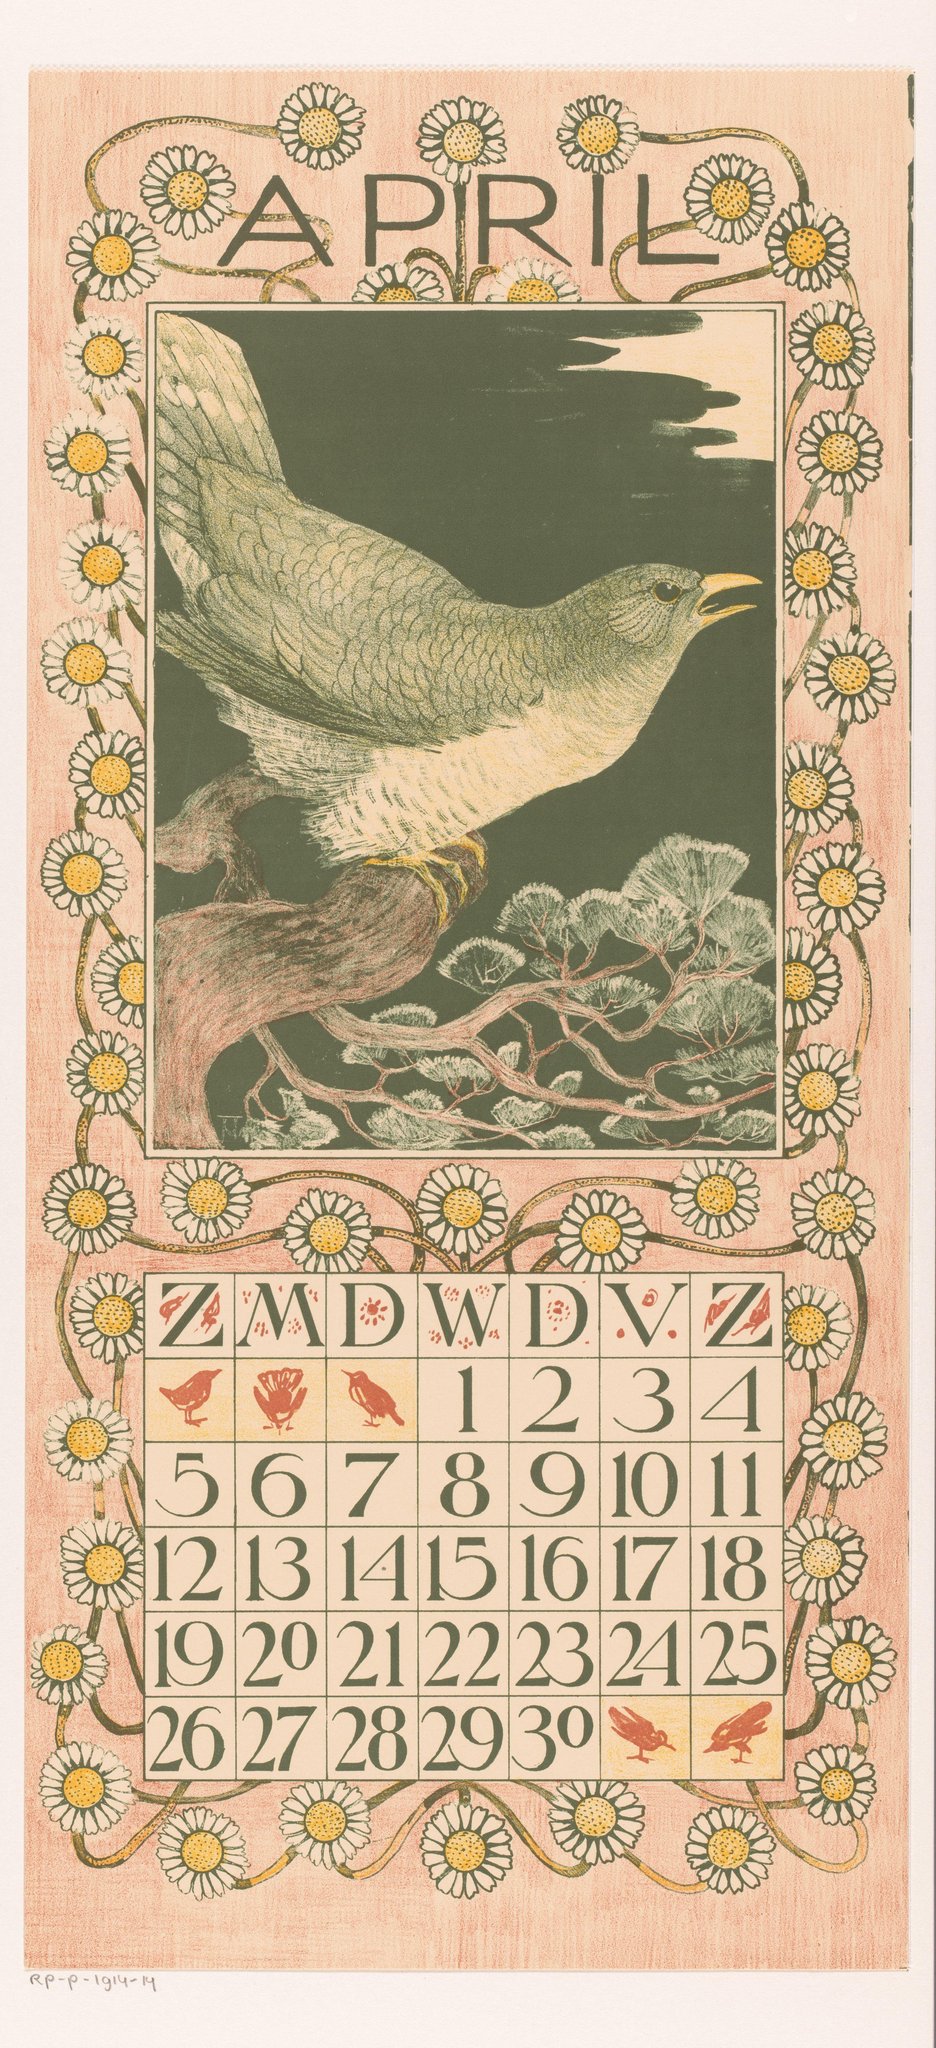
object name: print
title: Kalenderblad april met koekoek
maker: theo van hoytema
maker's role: draughtsman, painter, print maker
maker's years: 1863-1917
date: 1902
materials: paper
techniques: lithograph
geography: hilversum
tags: other birds: cuckoo, flowers: daisy, april ~ other concepts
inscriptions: collector's mark: Lugt 2228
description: De vogel zit op een tak. In de ornamentrand madeliefjes. Bovenaan het blad een scheurlijn.